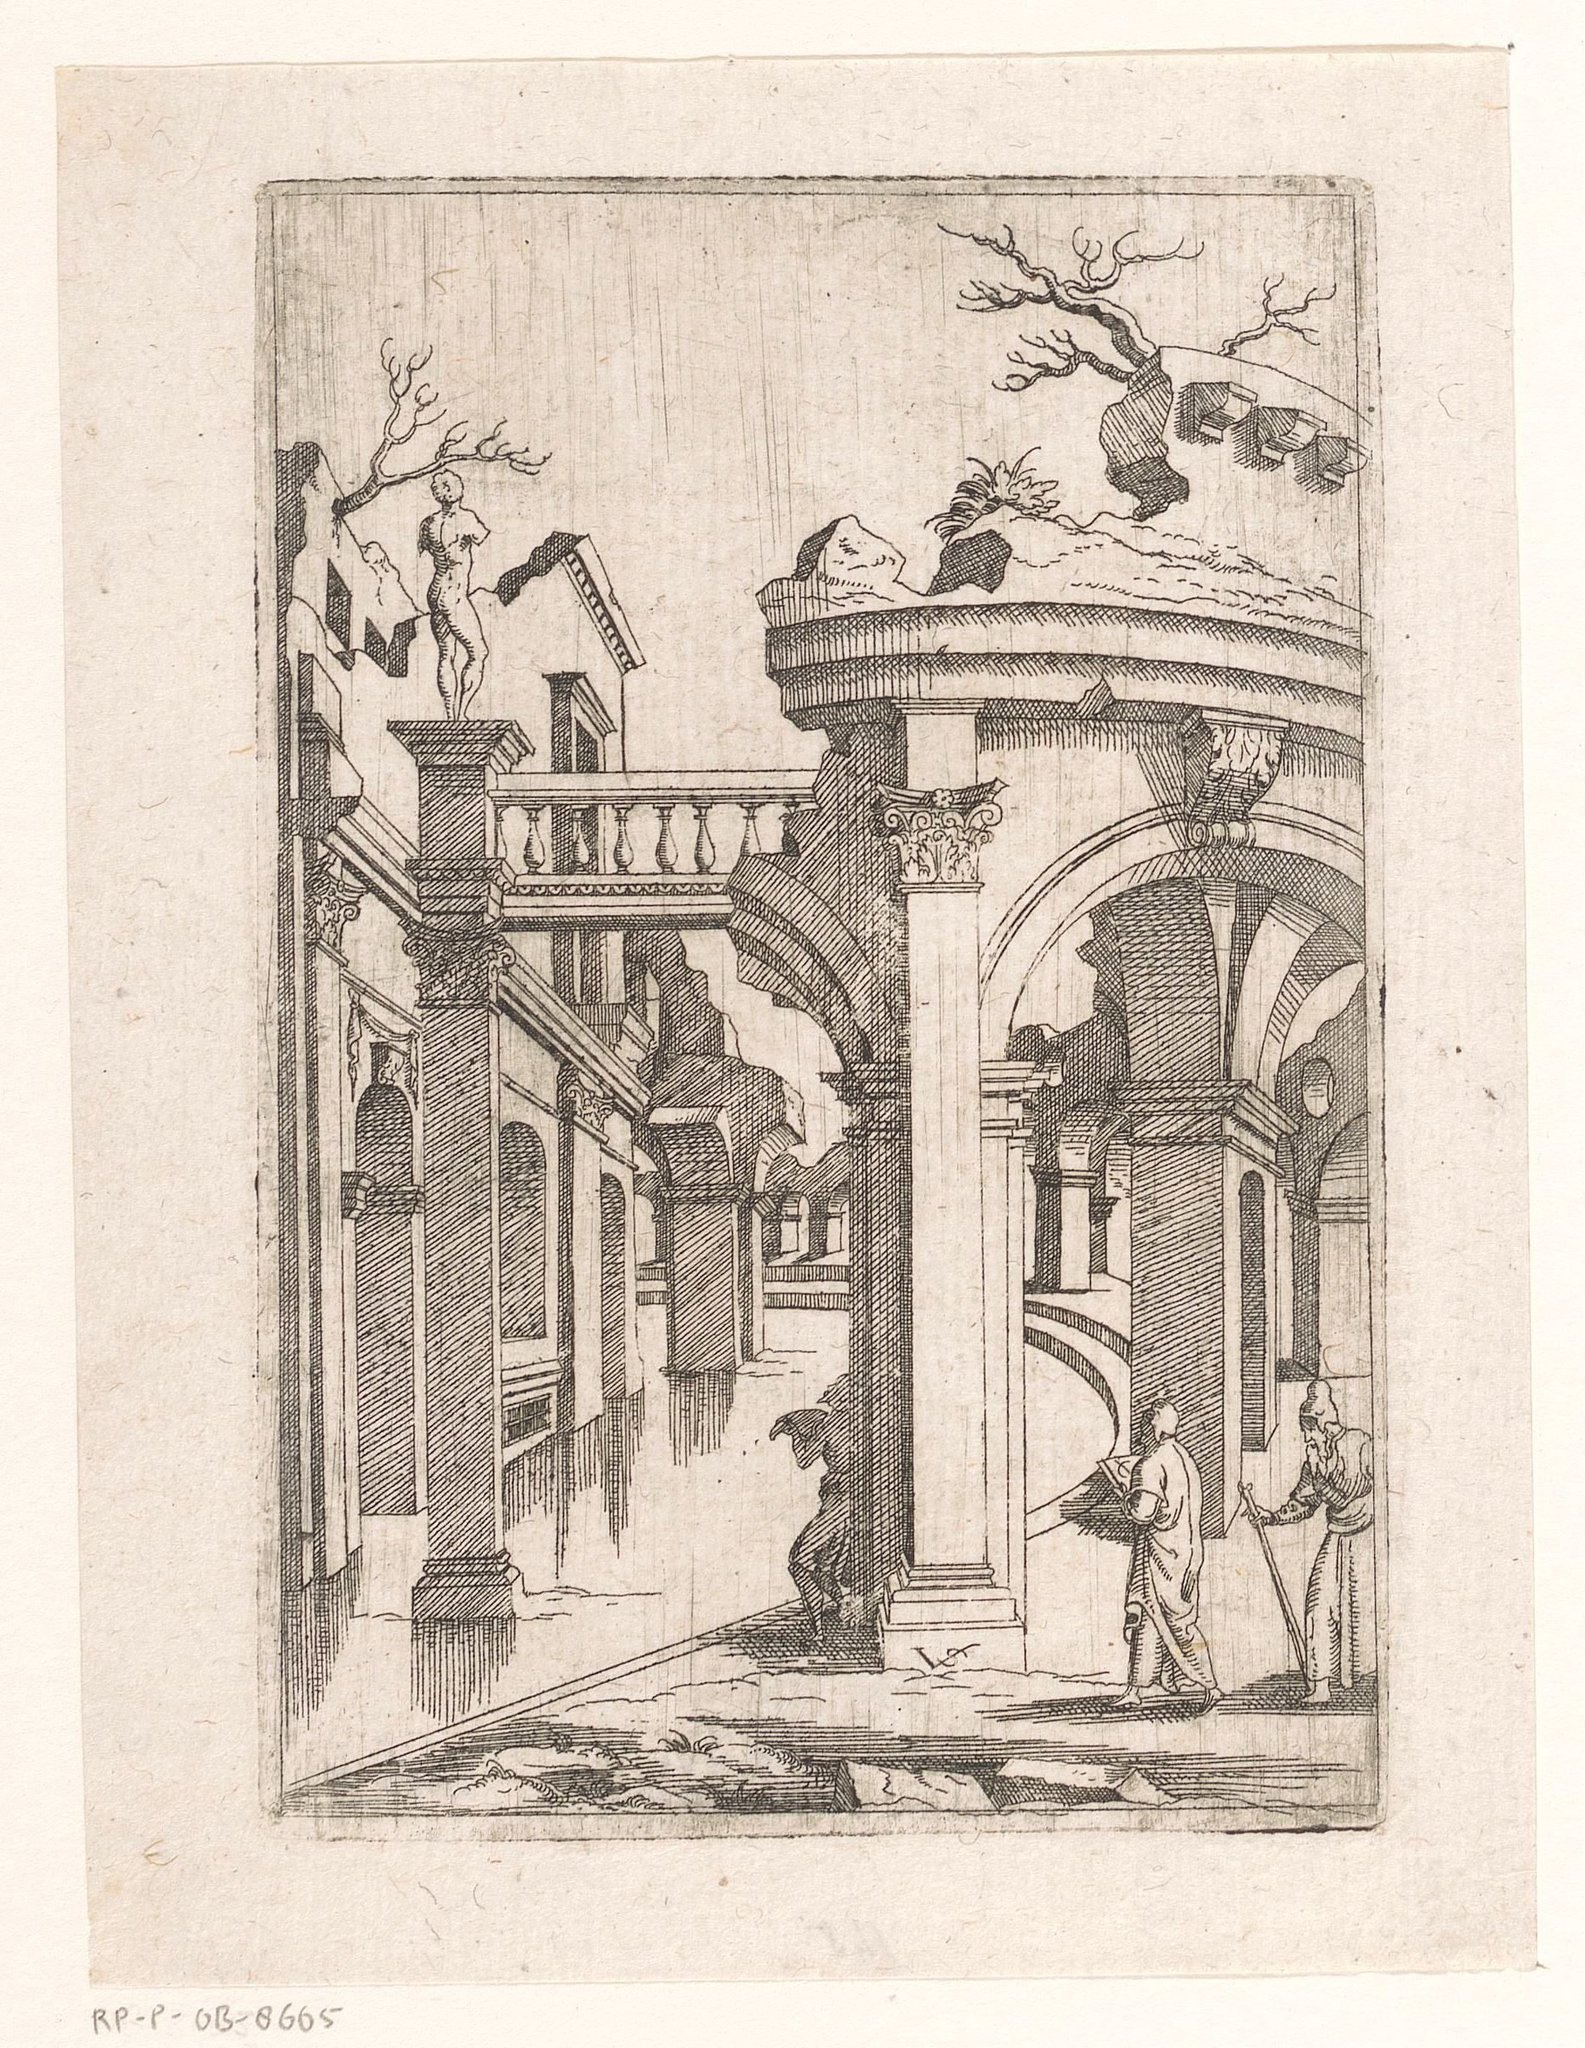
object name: print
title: Zuilengalerij rondom een bassin met twee staande tekenaars en een pelgrim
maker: virgilius solis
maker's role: draughtsman, print maker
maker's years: 1514-1562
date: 1550-1562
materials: paper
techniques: etching, intaglio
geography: nuremberg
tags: pilgrim(s), piece of sculpture, reproduction of a piece of sculpture, gallery (spacious corridor), draughtsman at work - cc - out of doors, draughtsman studying classical remains - cc - out of doors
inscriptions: collector's mark: Lugt 2228, number: ‘148’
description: Prent maakt deel uit van een serie die bestaat uit een titelprent en twaalf prenten met gezichten op ruïneuze bouwwerken met zittende en rondlopende figuren. Het betreft spiegelbeeldige kopieën naar een reeks prenten door Jacques Androuet naar ontwerp van Léonard Thiry.